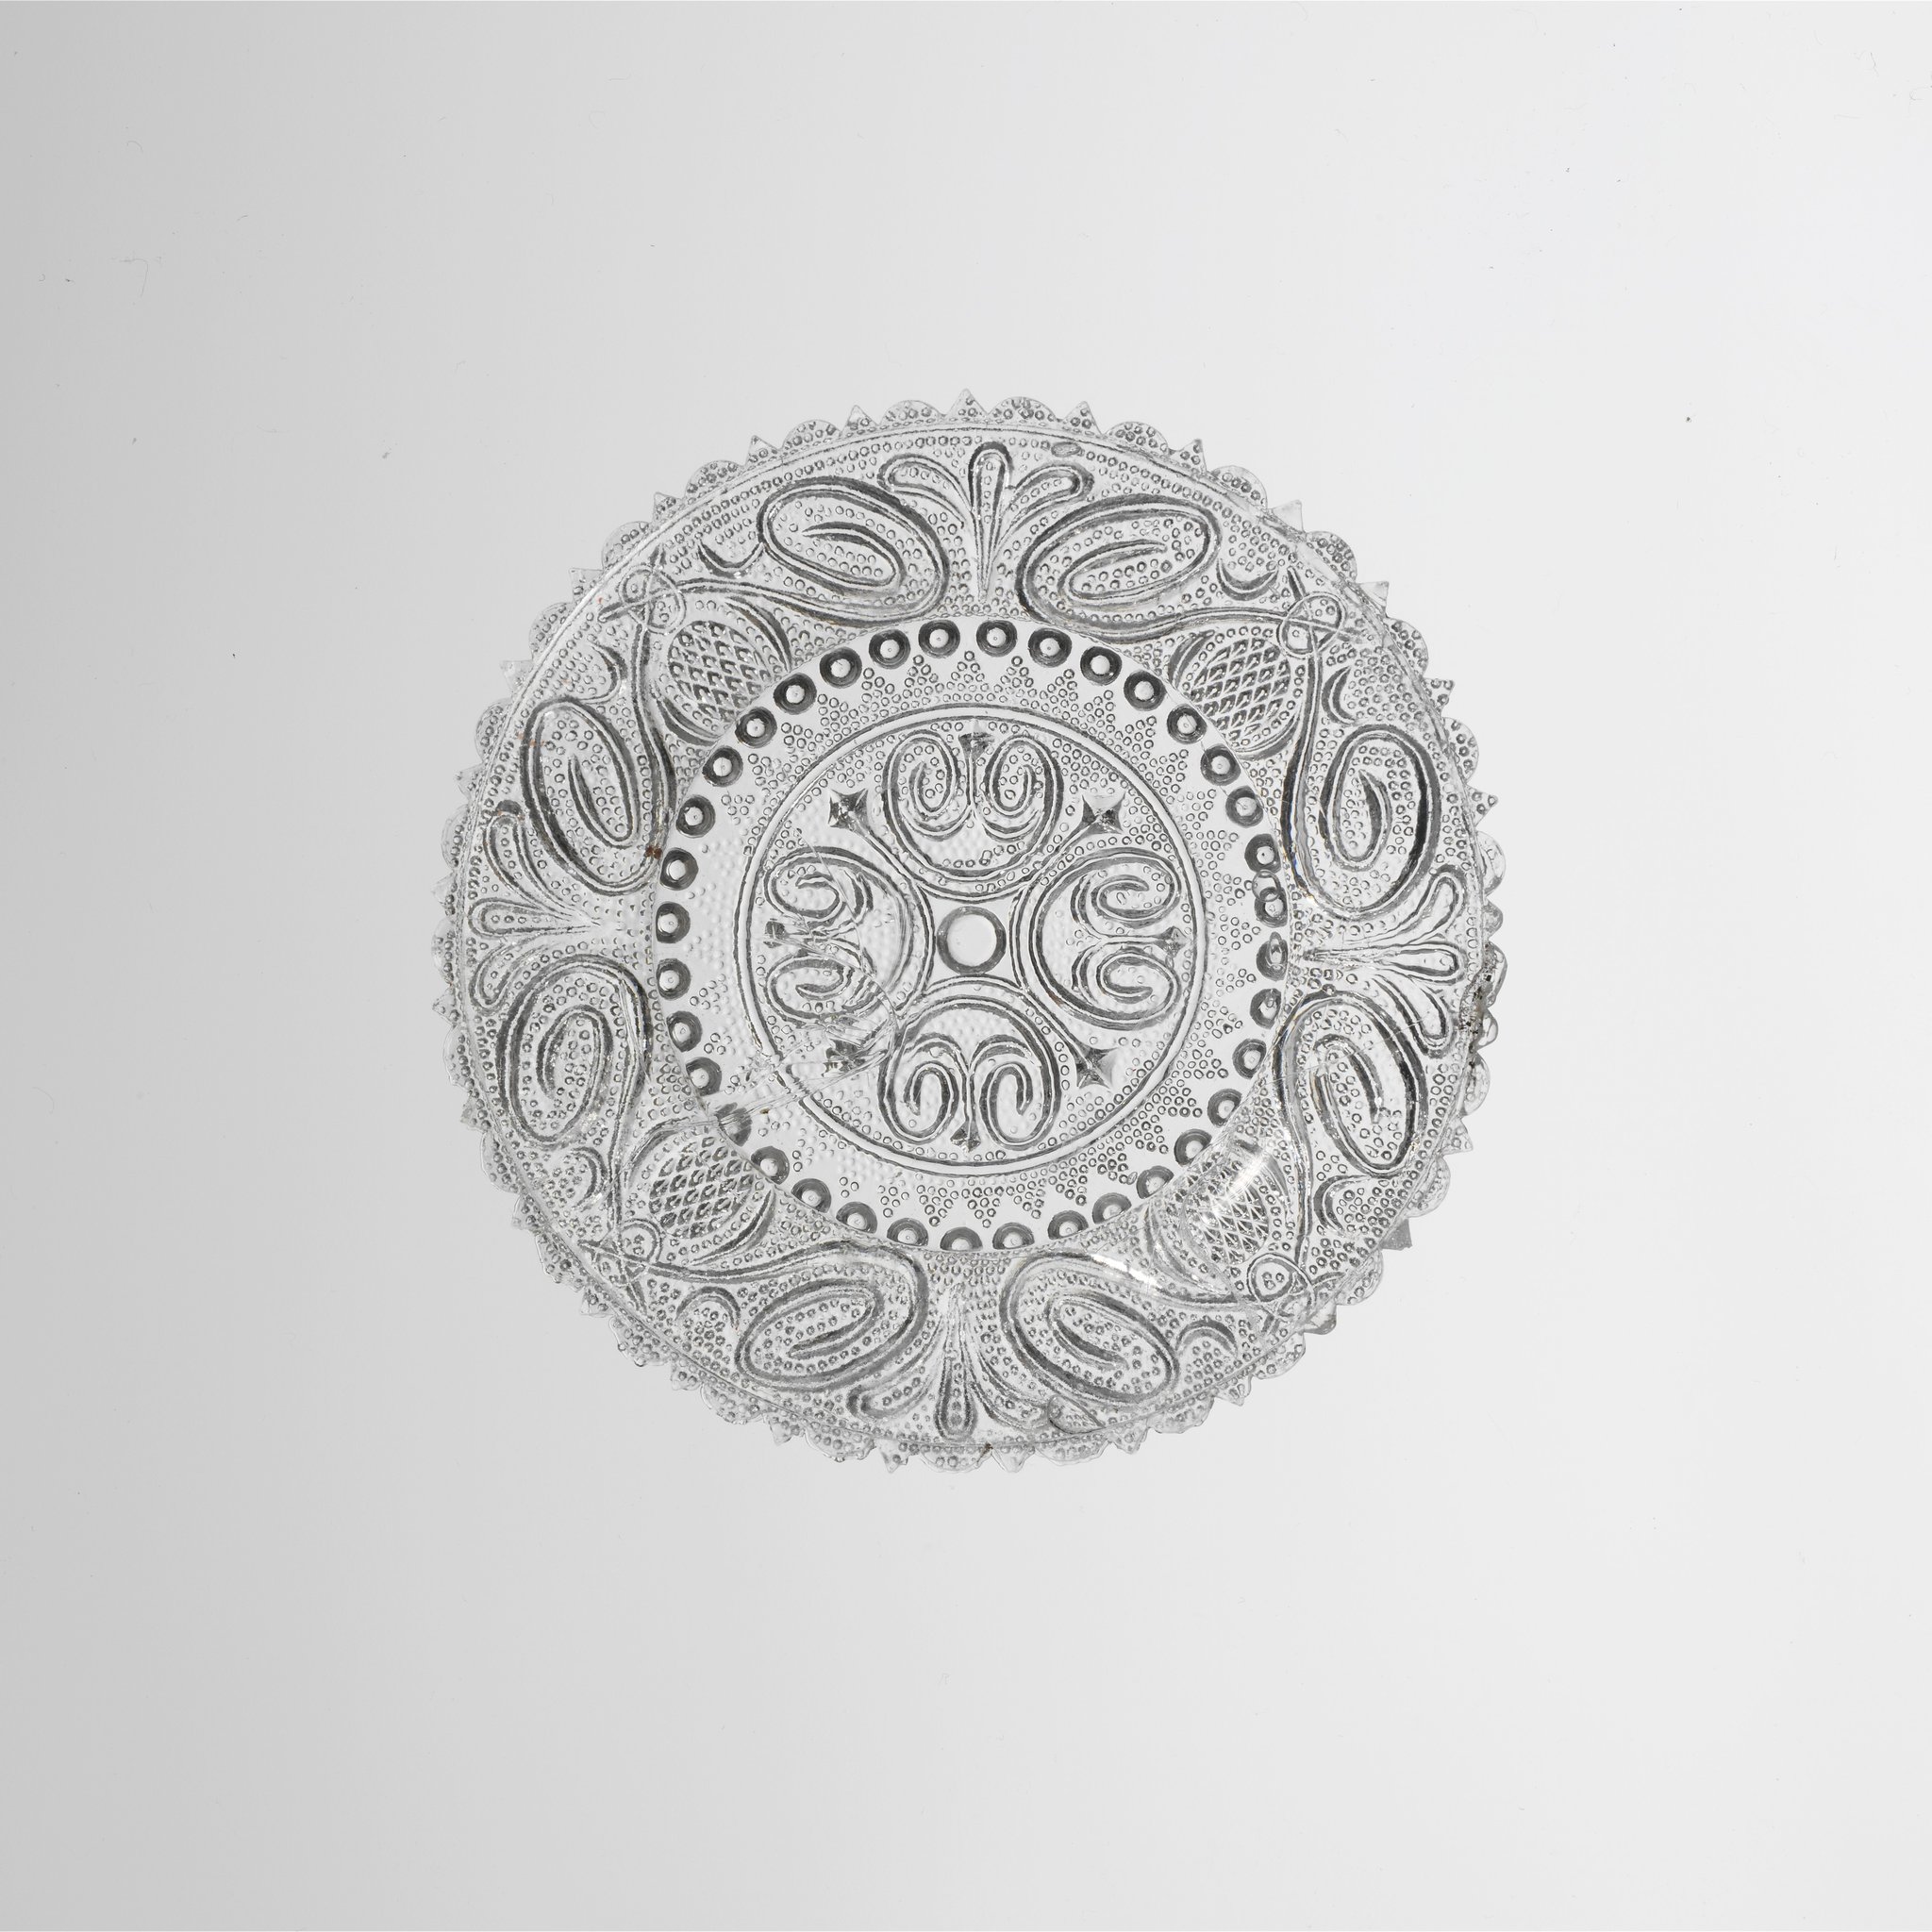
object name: cup plate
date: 1825-1860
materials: glass